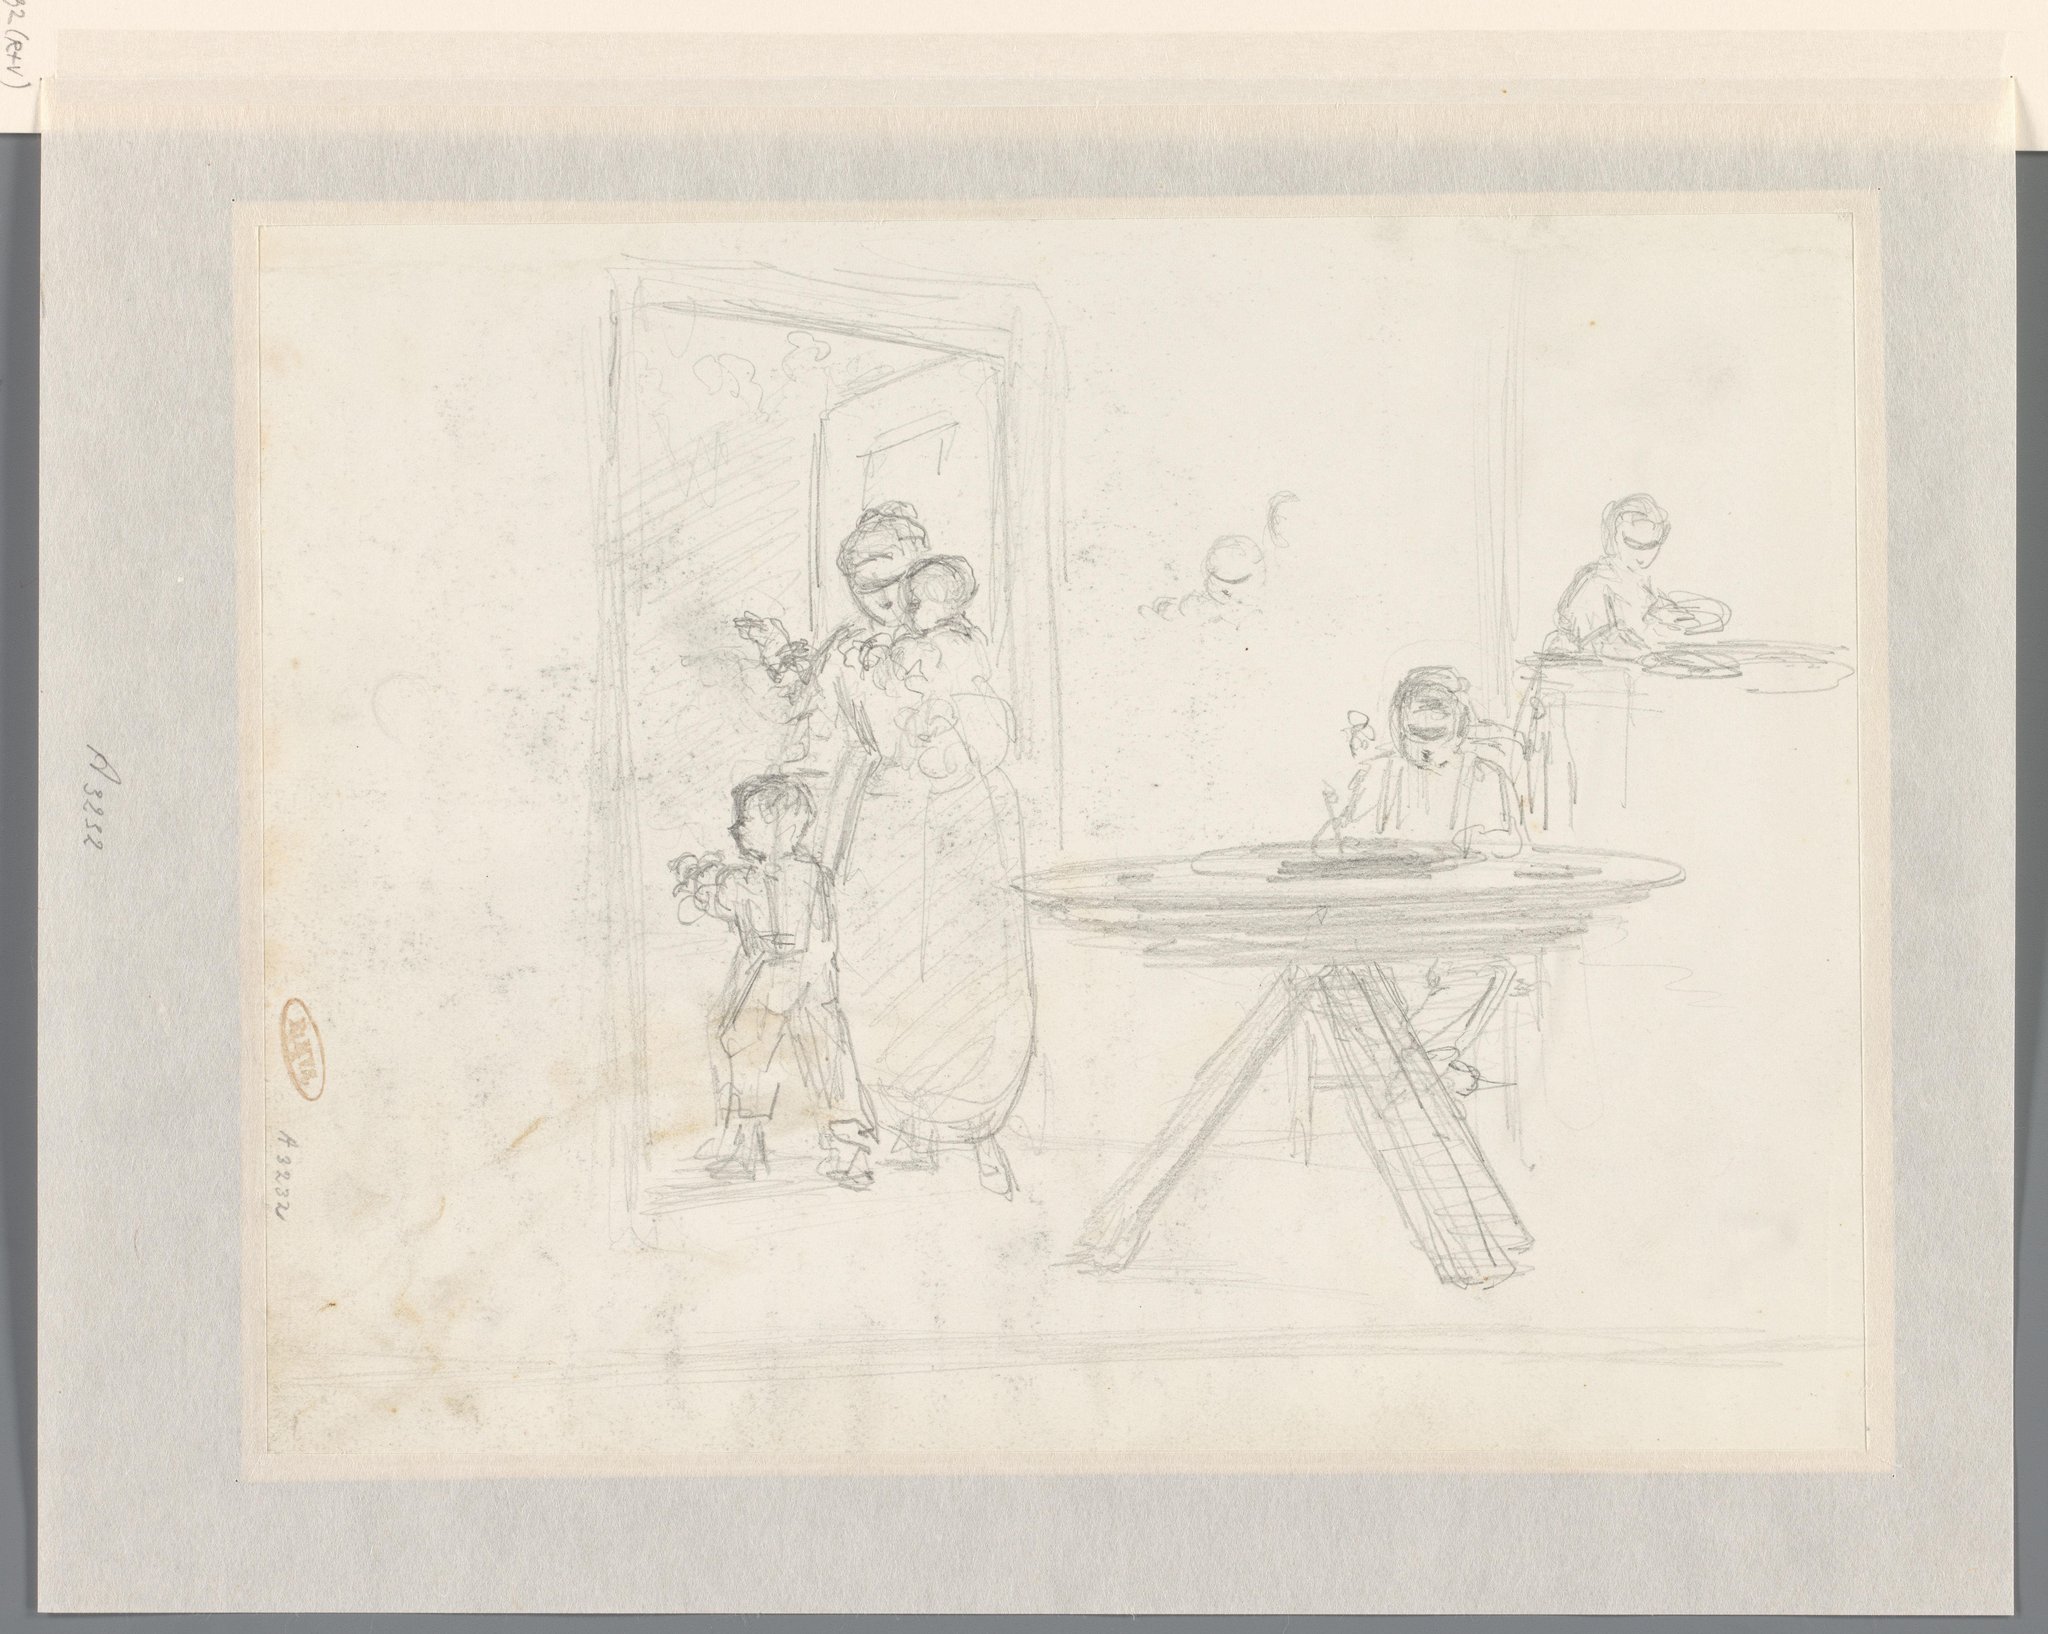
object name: drawing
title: Vissersmeisje en een vissersjongen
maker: hendrik valkenburg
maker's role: draughtsman, painter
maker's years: 1826-1896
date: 1836-1896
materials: paper, pencil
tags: adult woman, adult man, interior of the house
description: Vissersmeisje bij een hek, aan de andere zijde een vissersjongen. Verso: Interieur met moeder en kinderen.